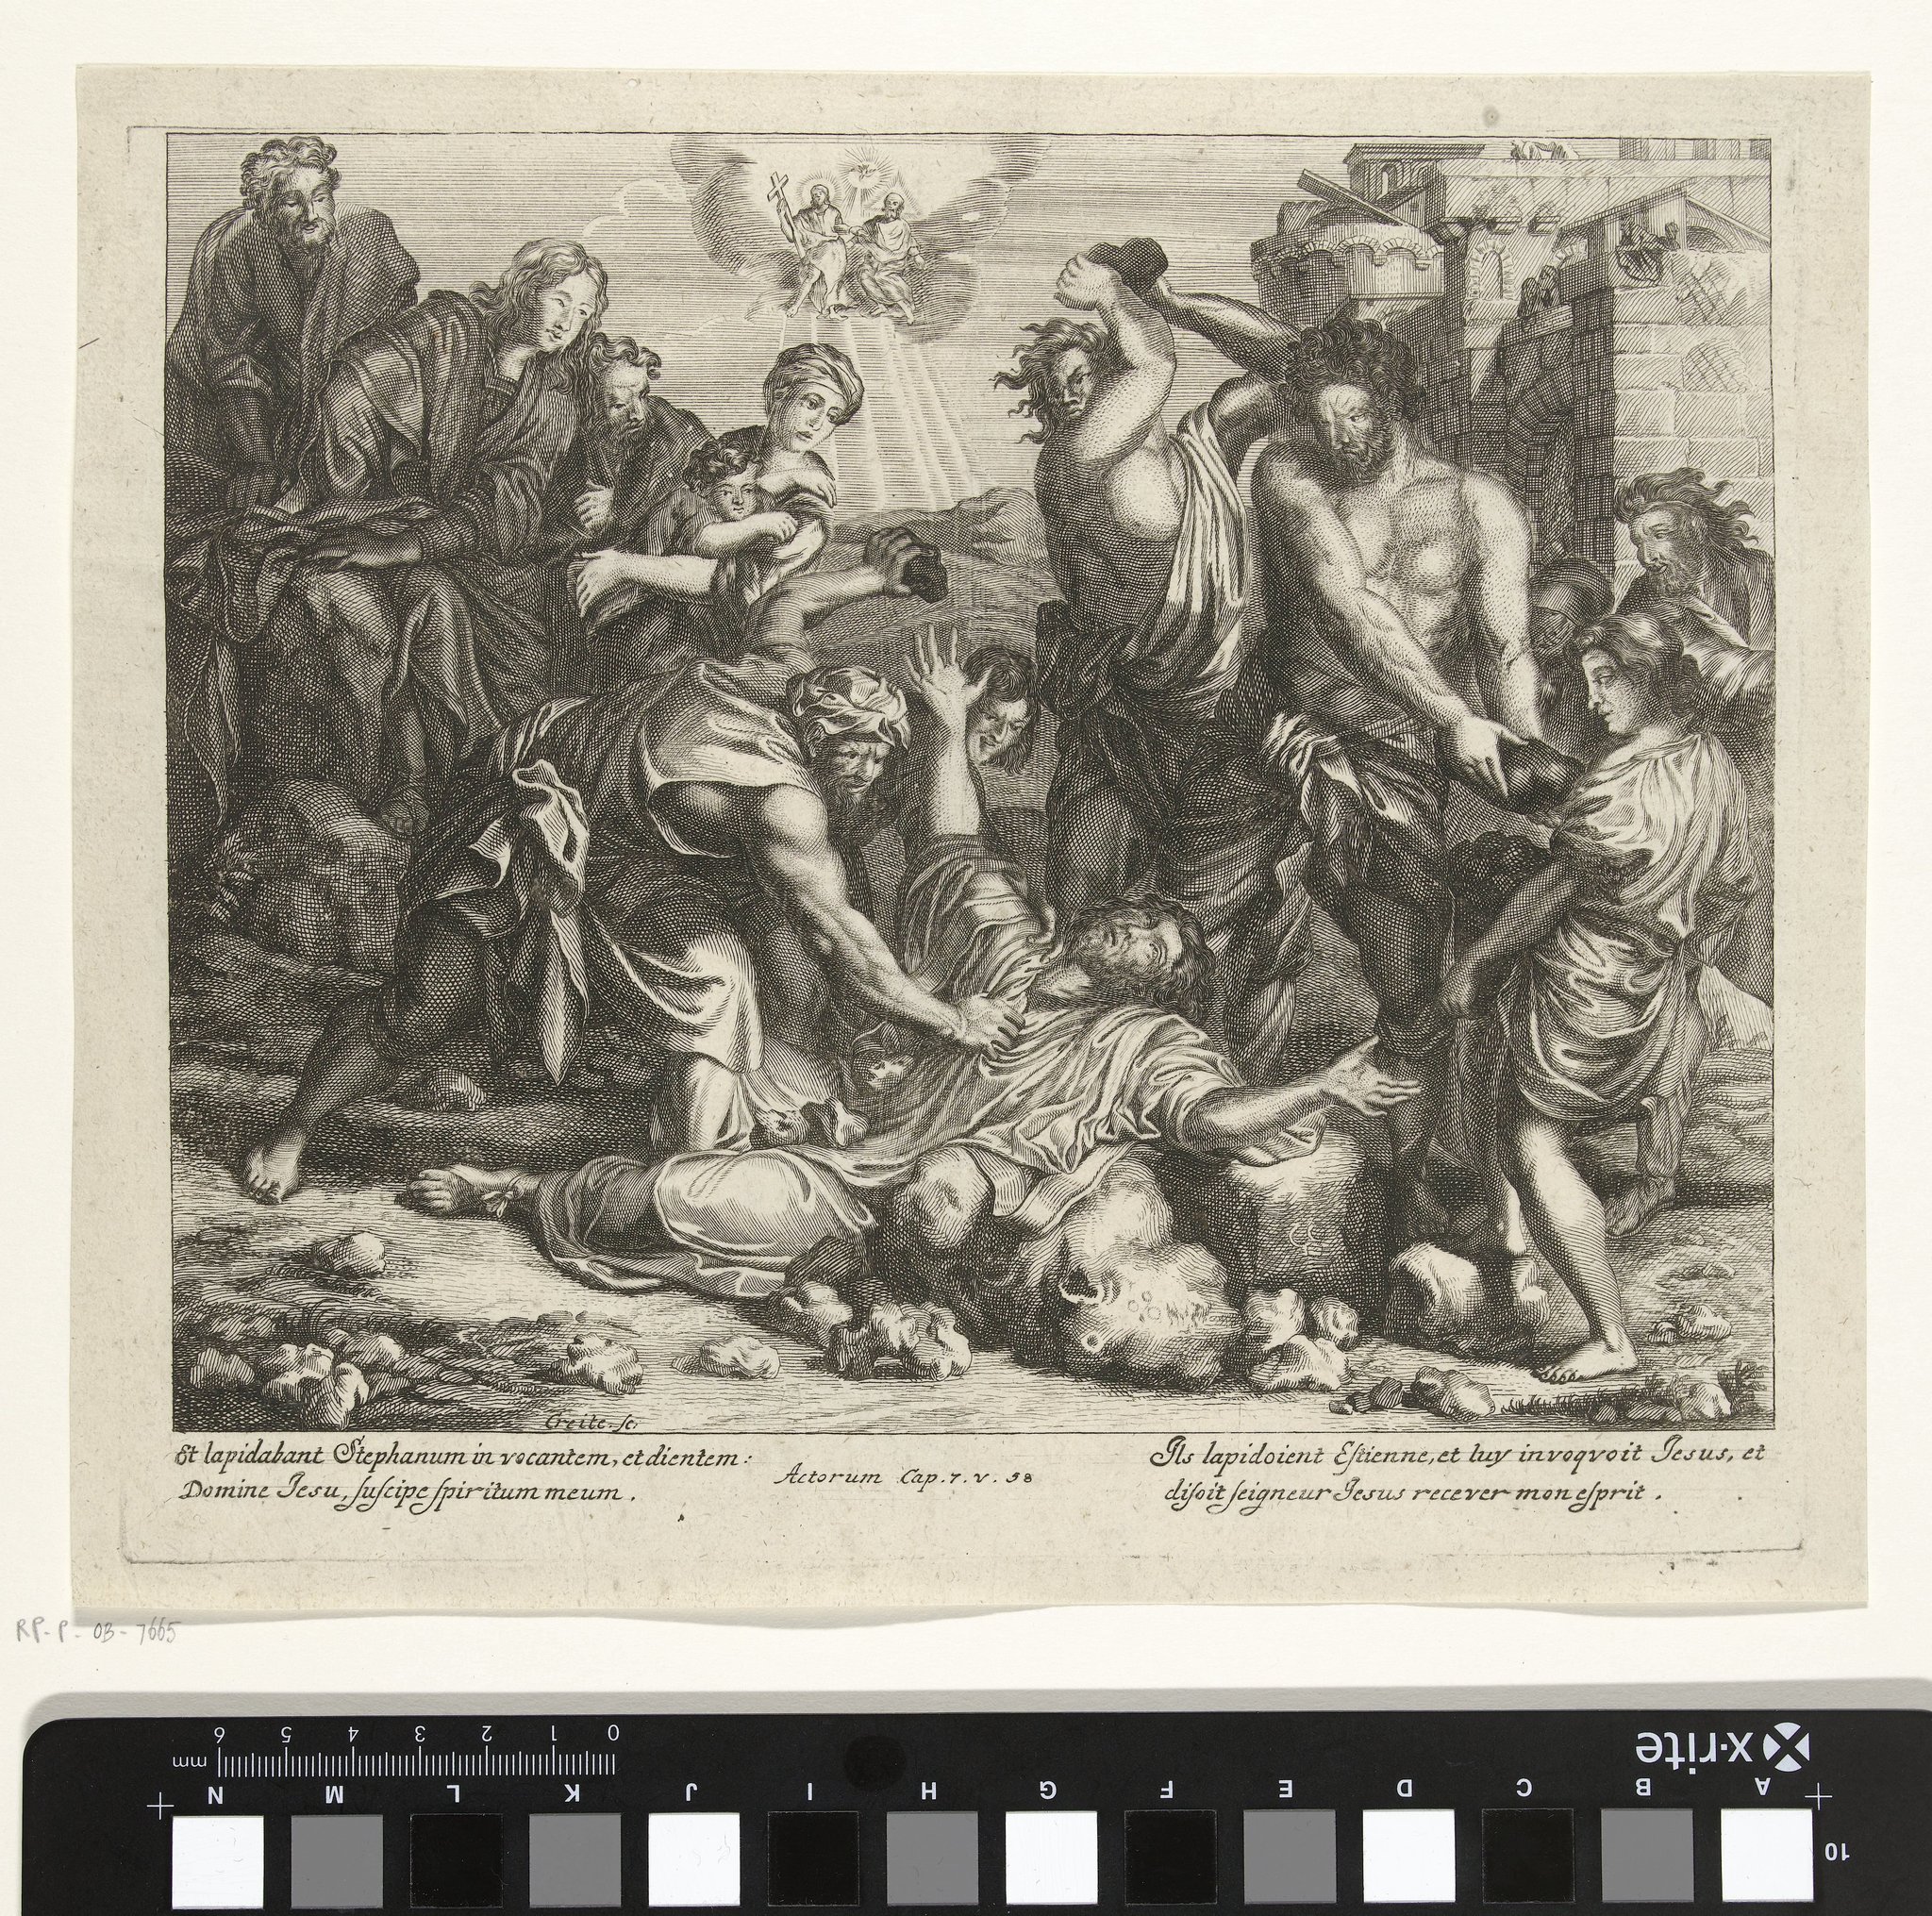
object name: print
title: Steniging van de Heilige Stefanus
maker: ernst ludwig creite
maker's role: print maker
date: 1739-1765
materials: paper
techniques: engraving, etching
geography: the hague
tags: the stoning of stephen; the witnesses lay down their clothes at saul's feet, trinity in which god the father and christ are represented as persons, the holy ghost as dove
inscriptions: collector's mark: Lugt 2228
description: Stefanus ligt op de grond en wordt door verscheidene mannen gestenigd. Rechts de muren van de stad Jeruzalem. In de achtergrond de Heilige Drievuldigheid. De prent heeft een Latijns en een Frans onderschrift.